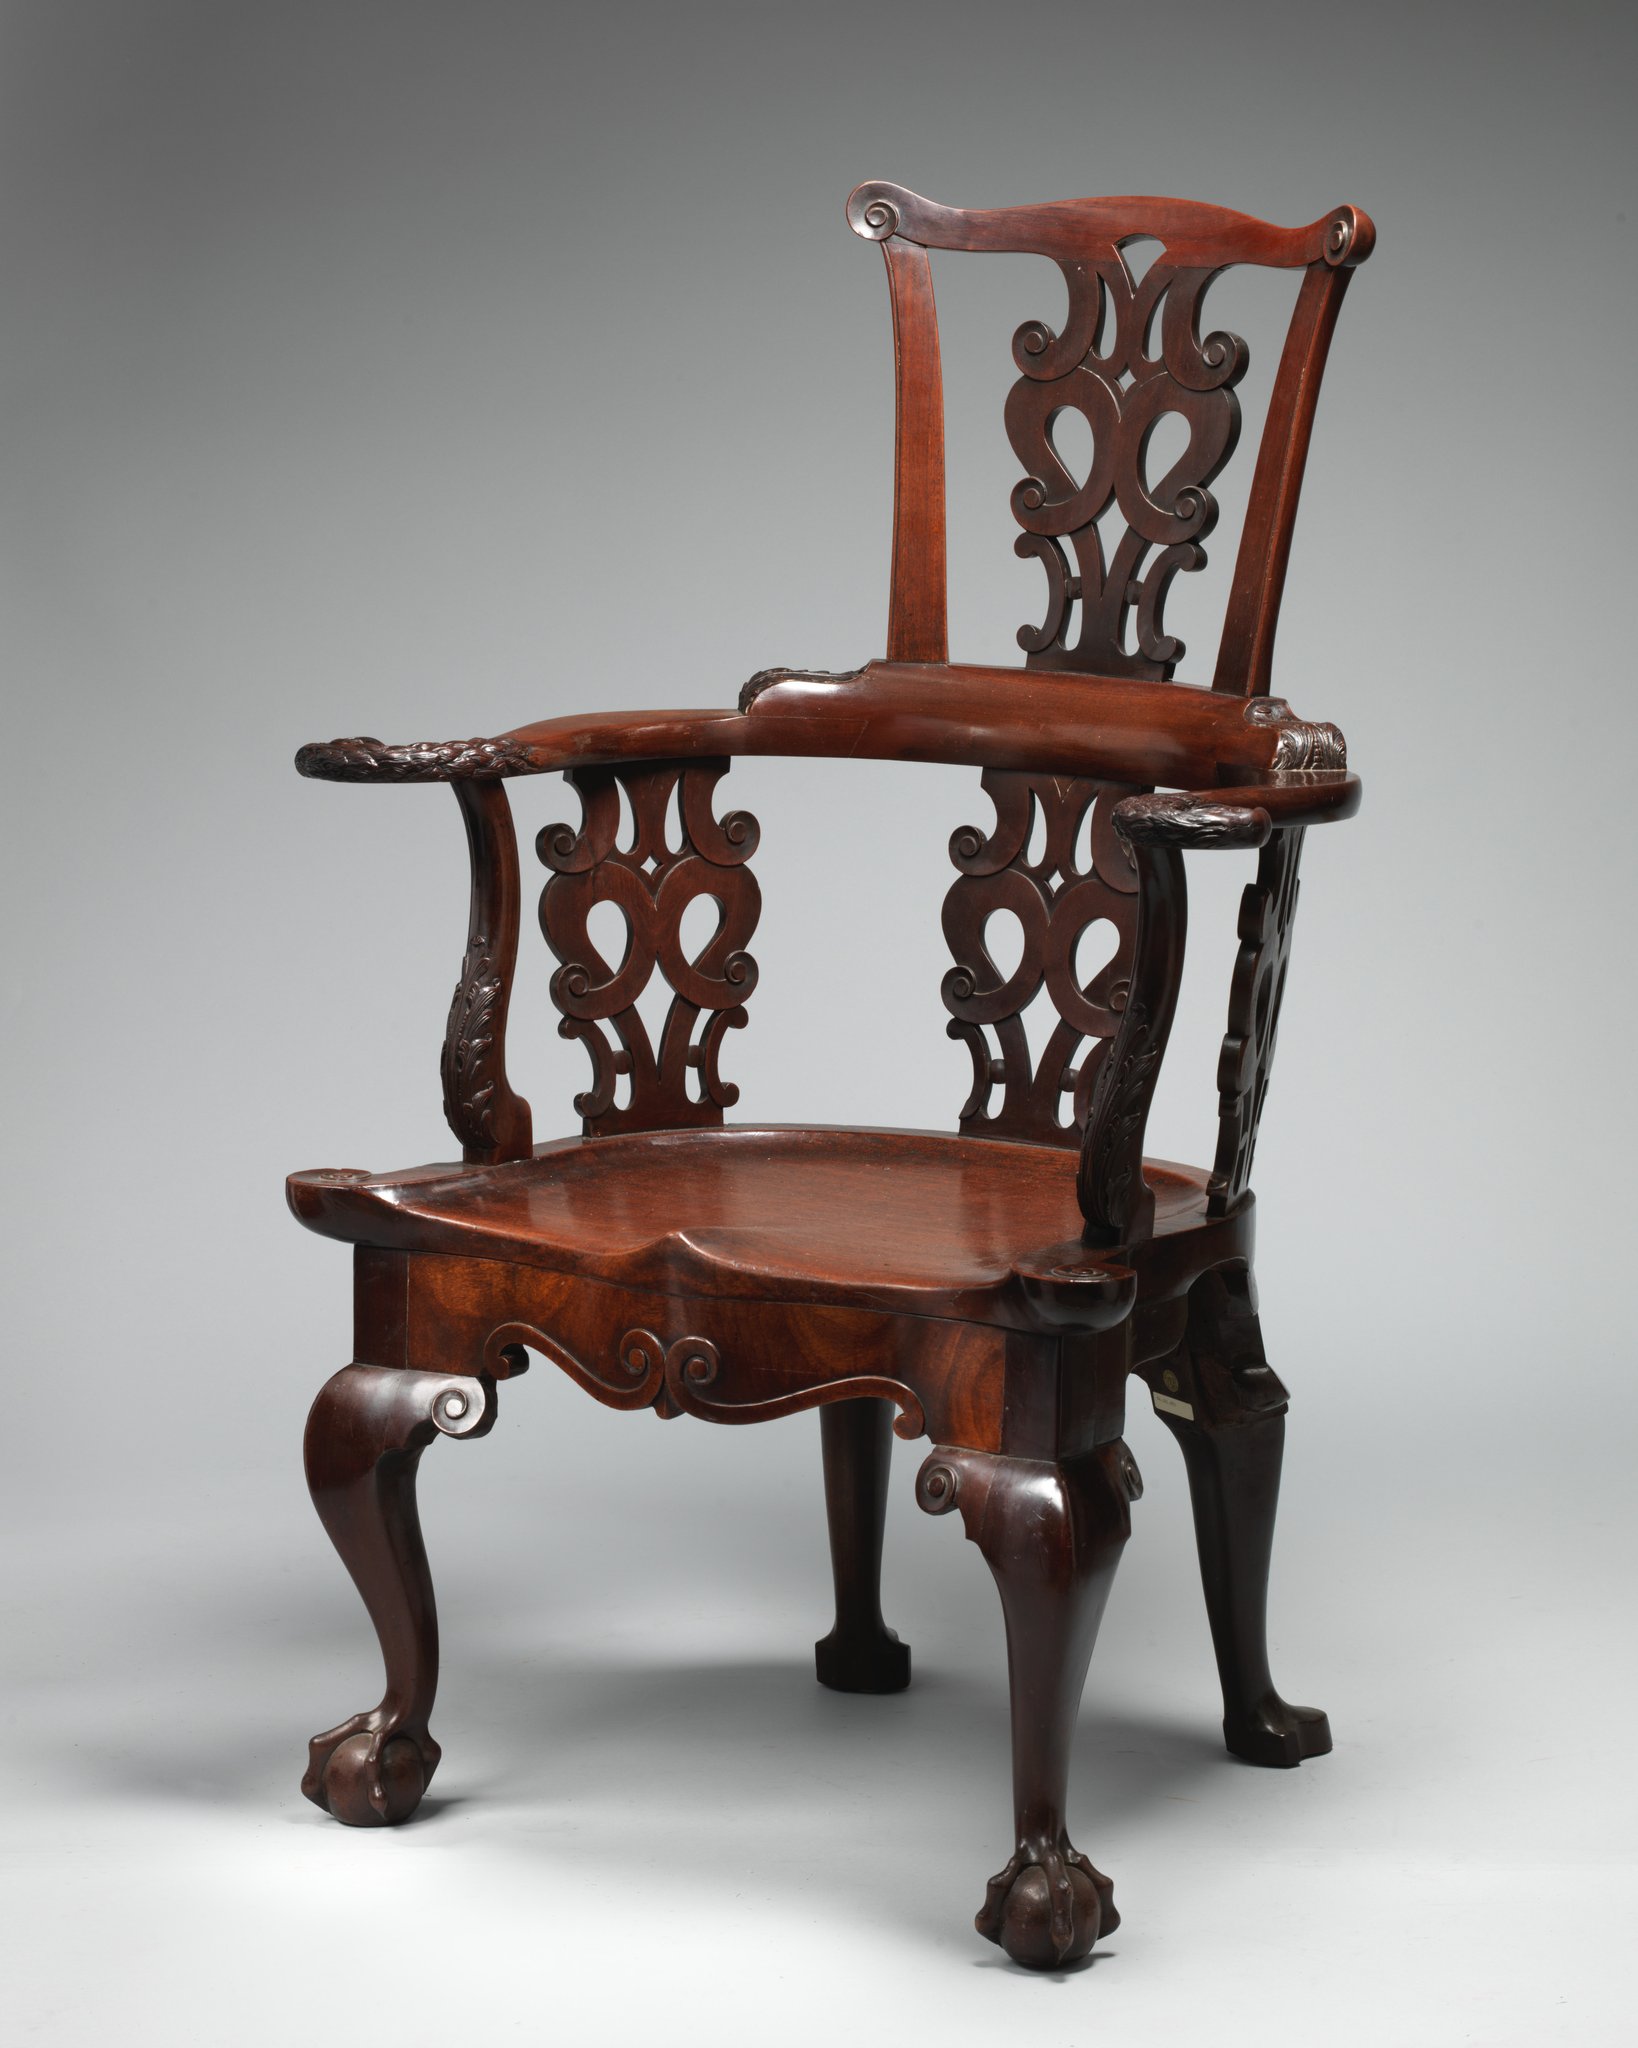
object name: armchair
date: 1740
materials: wood